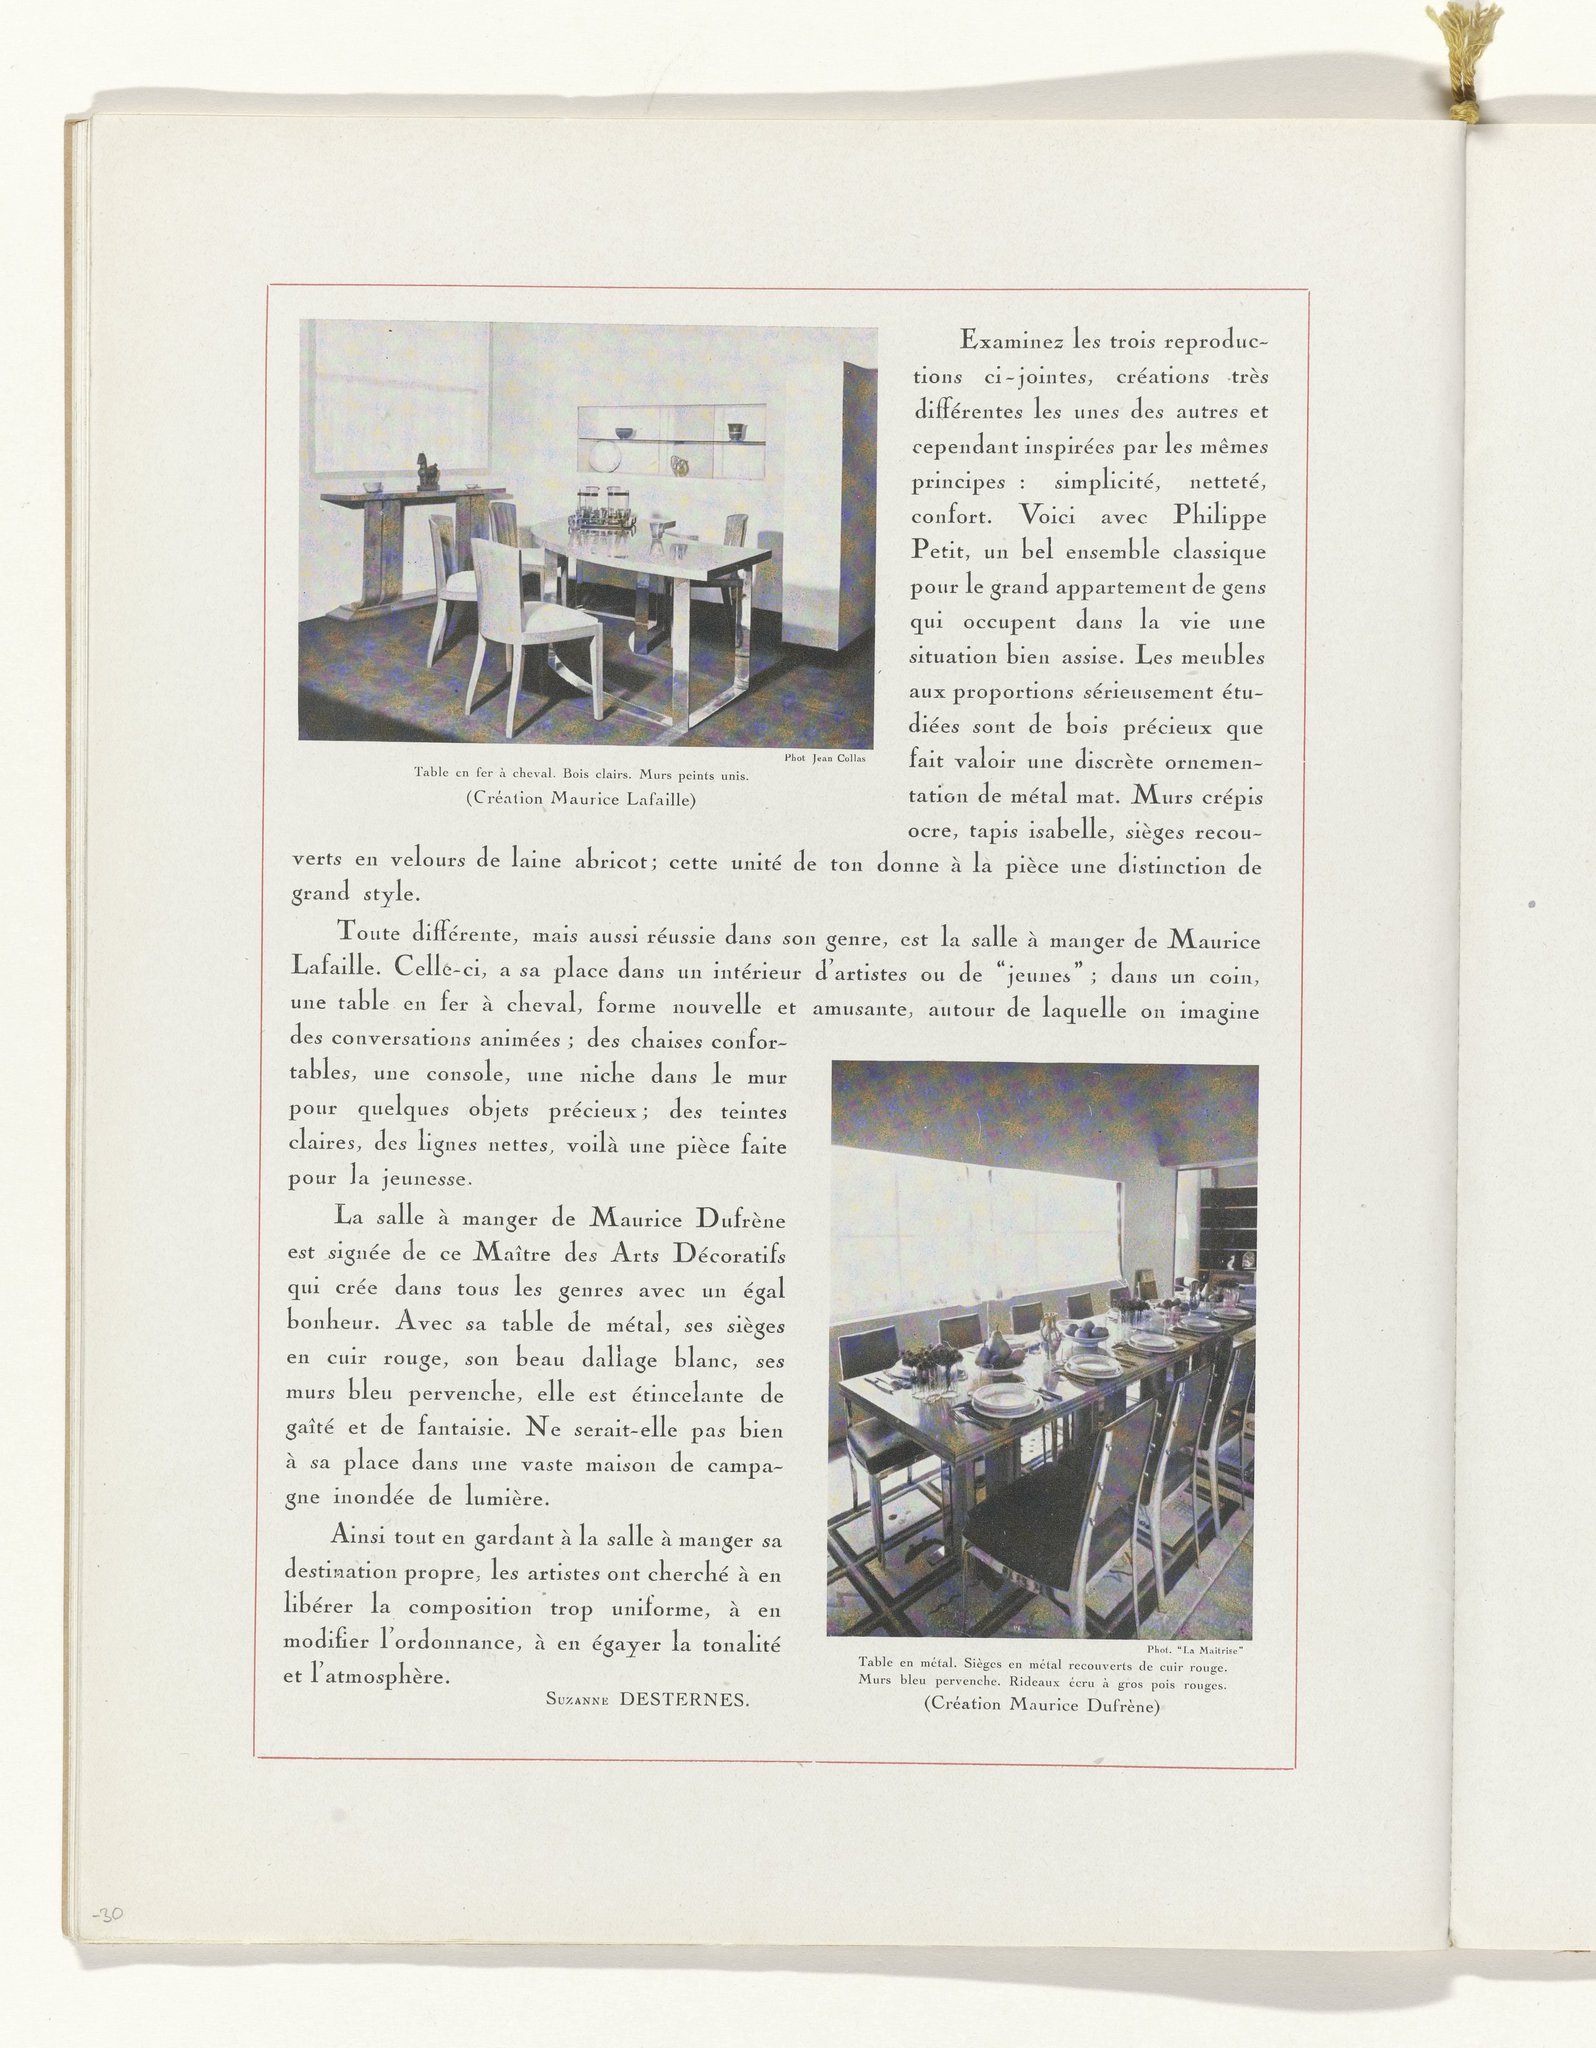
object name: magazine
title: Art - Goût - Beauté, Feuillets de l' élégance féminine, Novembre 1931, No. 135, 12e Année, p. 230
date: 1931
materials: paper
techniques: printing, photography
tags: fashion plates, table, dining-room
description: Tekst met twee afbeeldingen van een eettafels van Maurice Lafaille en Maurice Dufrène. Pagina uit het modetijdschrift Art-Goût-Beauté (1920-1933).